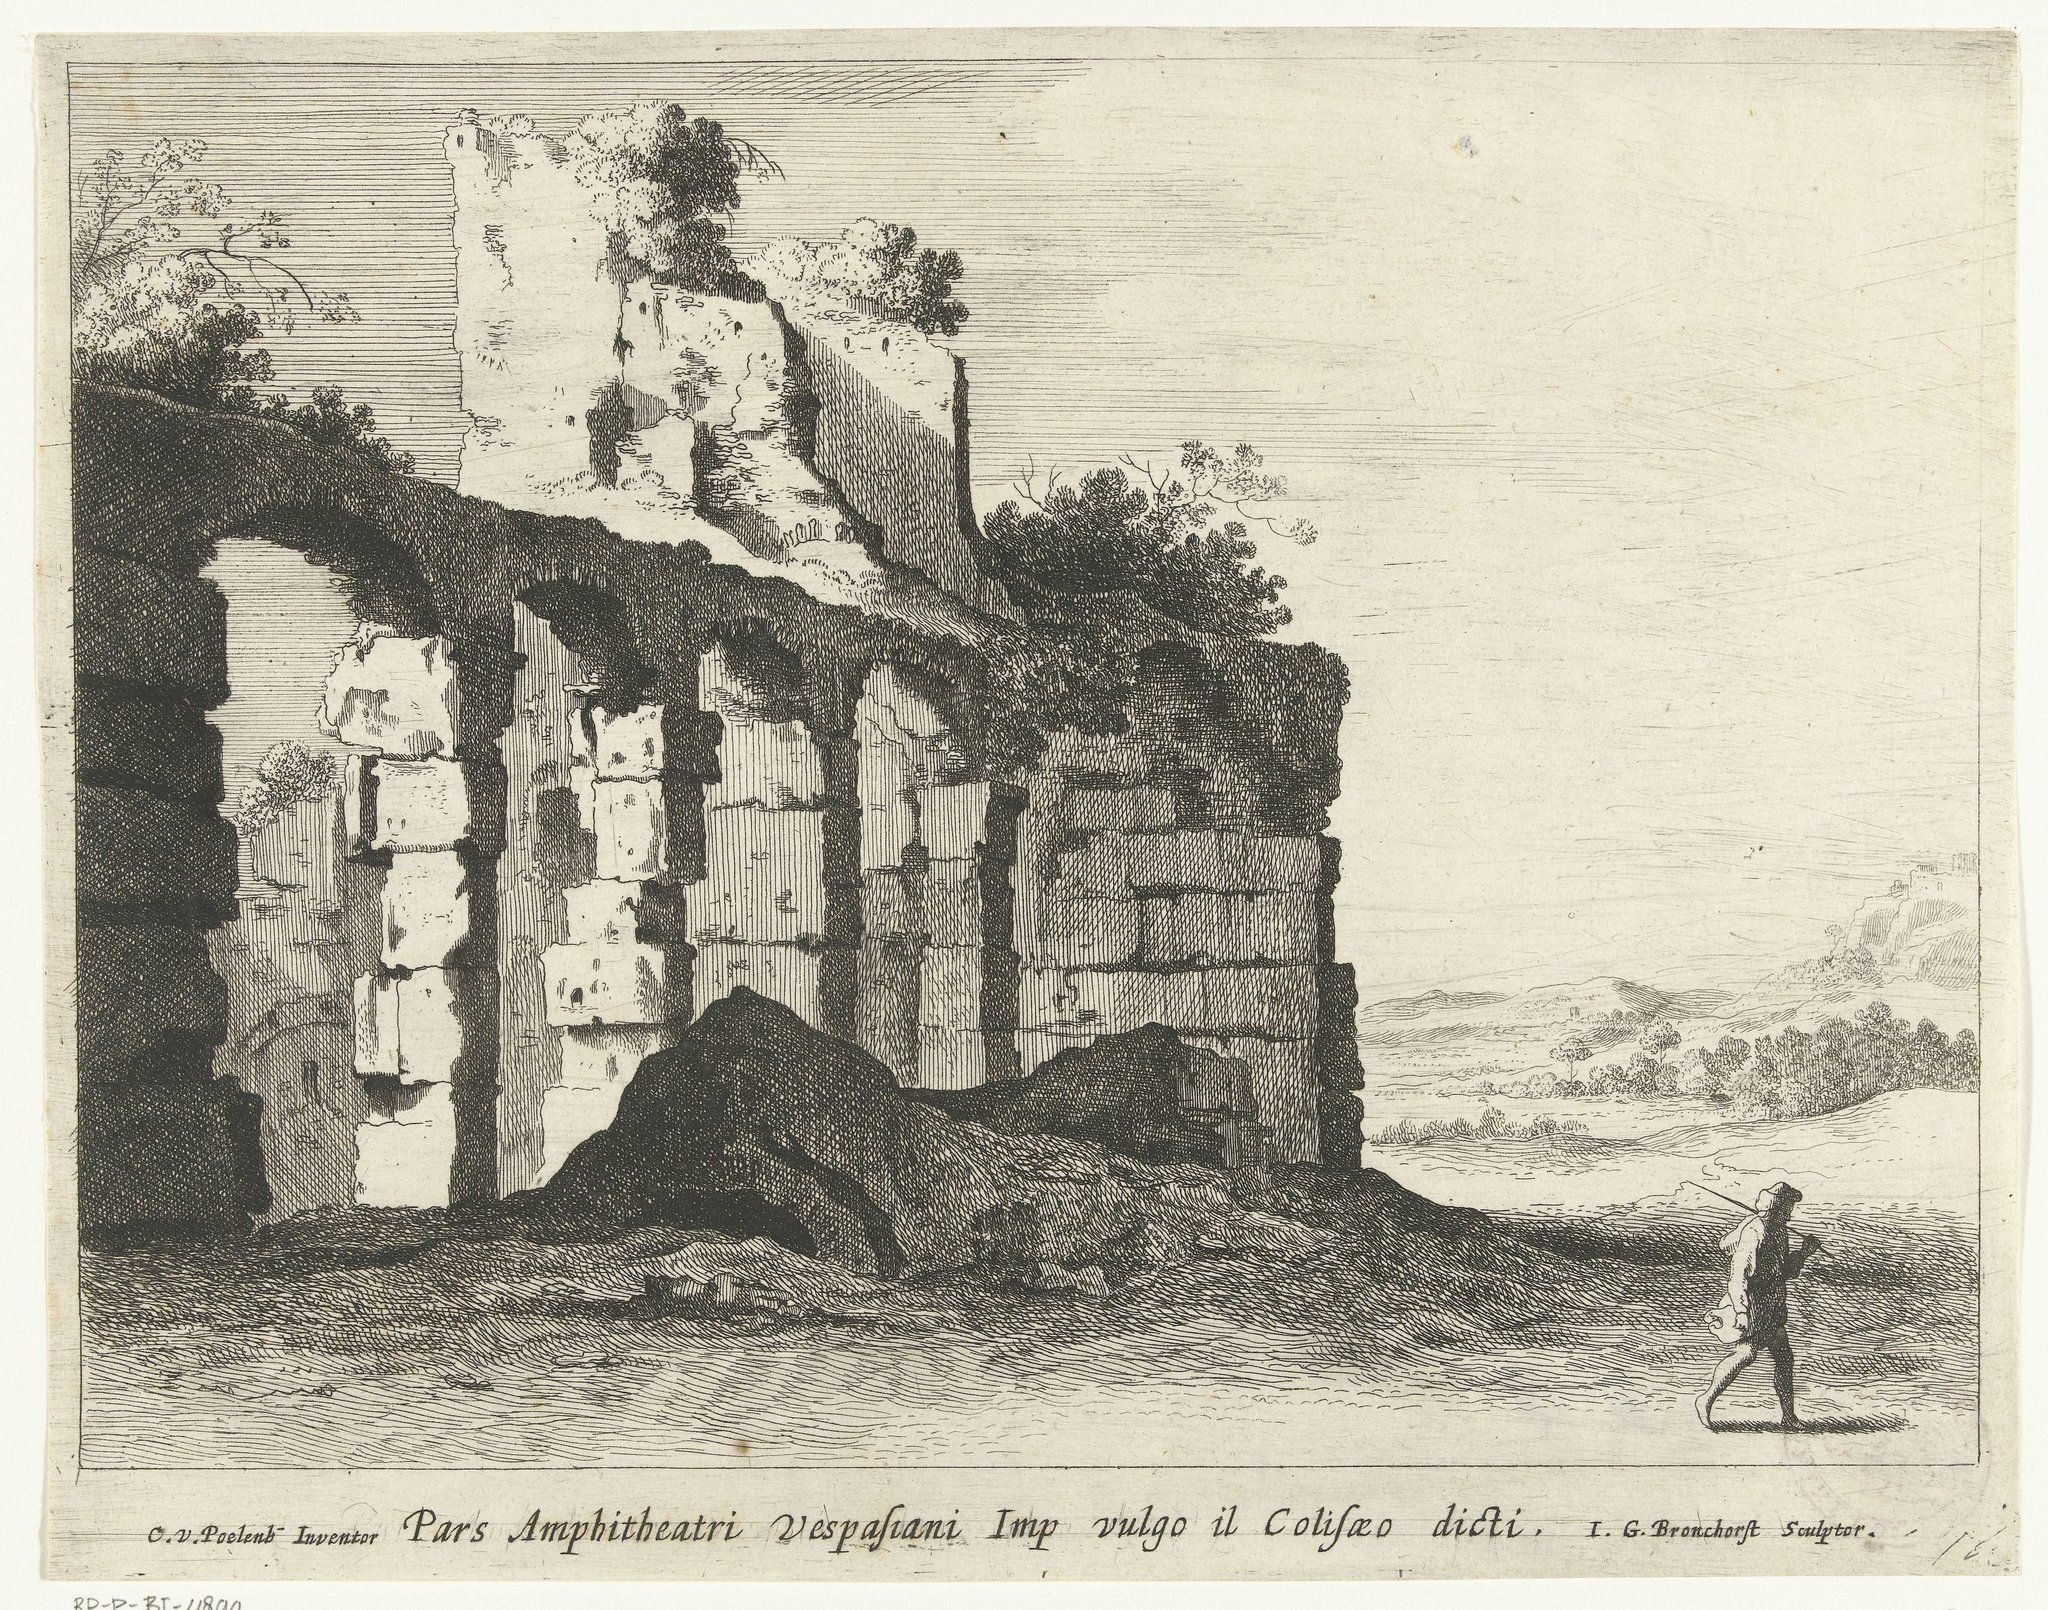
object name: print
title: Pars Amphitheatri Vespasiani Imp vulgo il Colisaeo dicti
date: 1613-1661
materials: paper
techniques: etching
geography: netherlands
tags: ruin of a building ~ architecture, landscape with ruins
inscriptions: collector's mark: Lugt 240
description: Prent naar ontwerp van Cornelis van Poelenburch. Prent uit serie van negen prenten met Romeinse ruïnes.